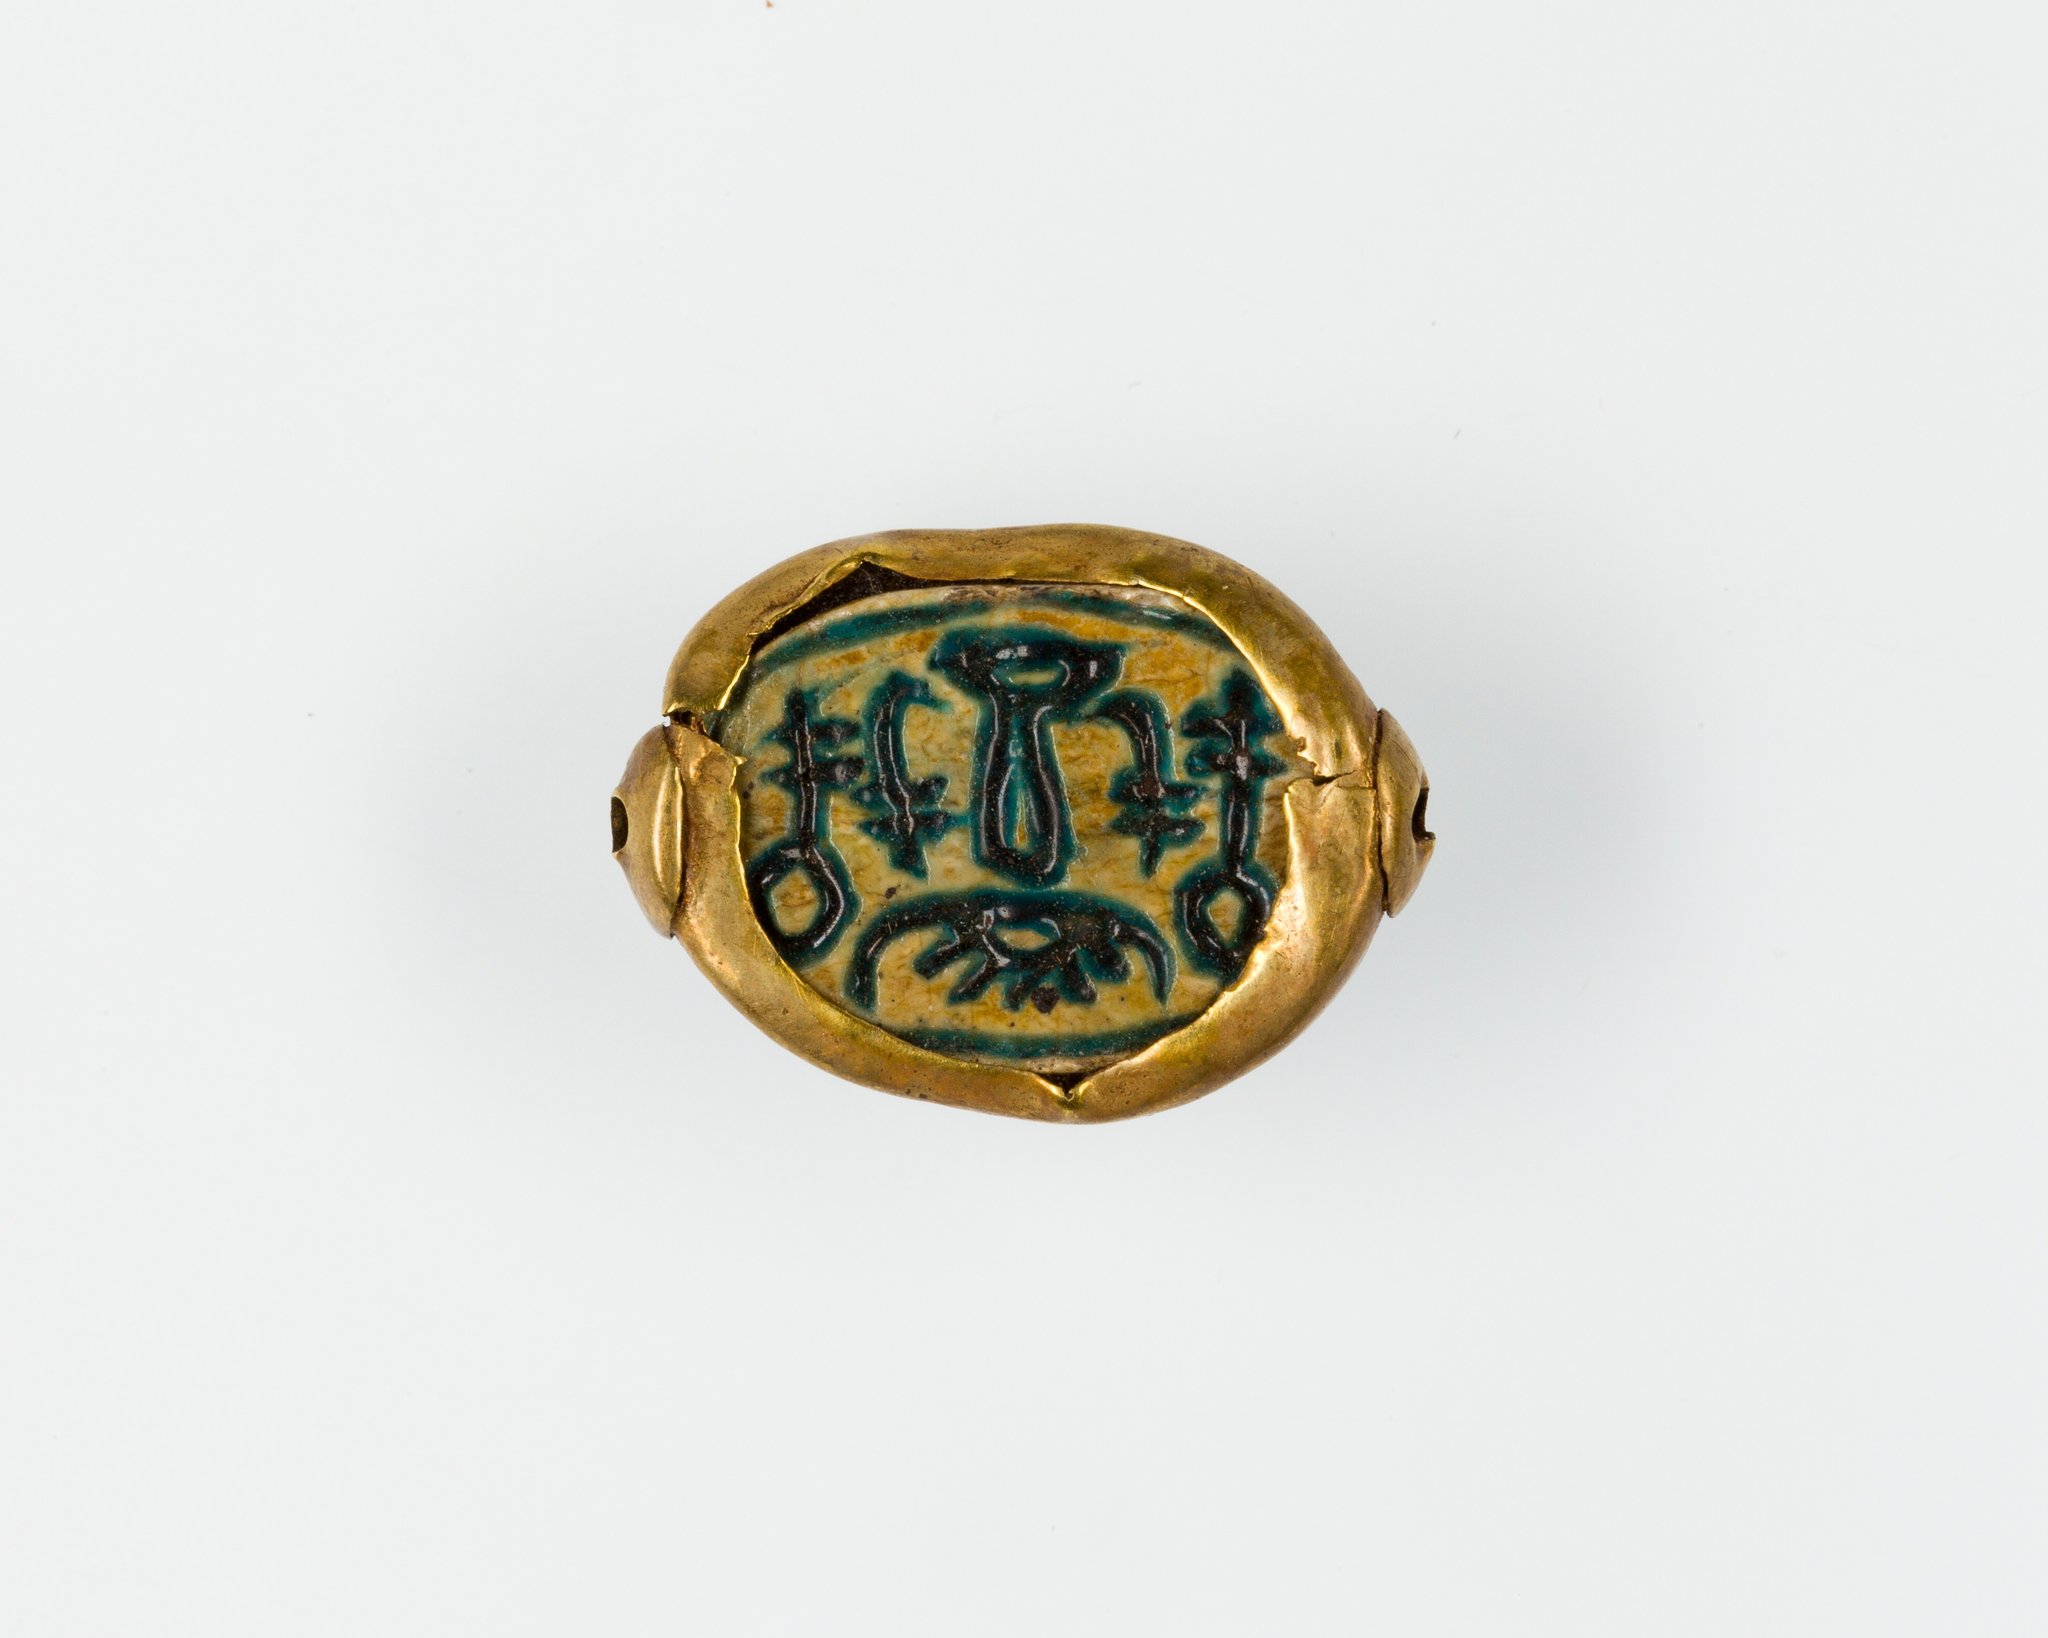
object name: scarab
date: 1786-1482 BCE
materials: gold, stone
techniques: glazing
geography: egypt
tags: hieroglyphs,scarabs